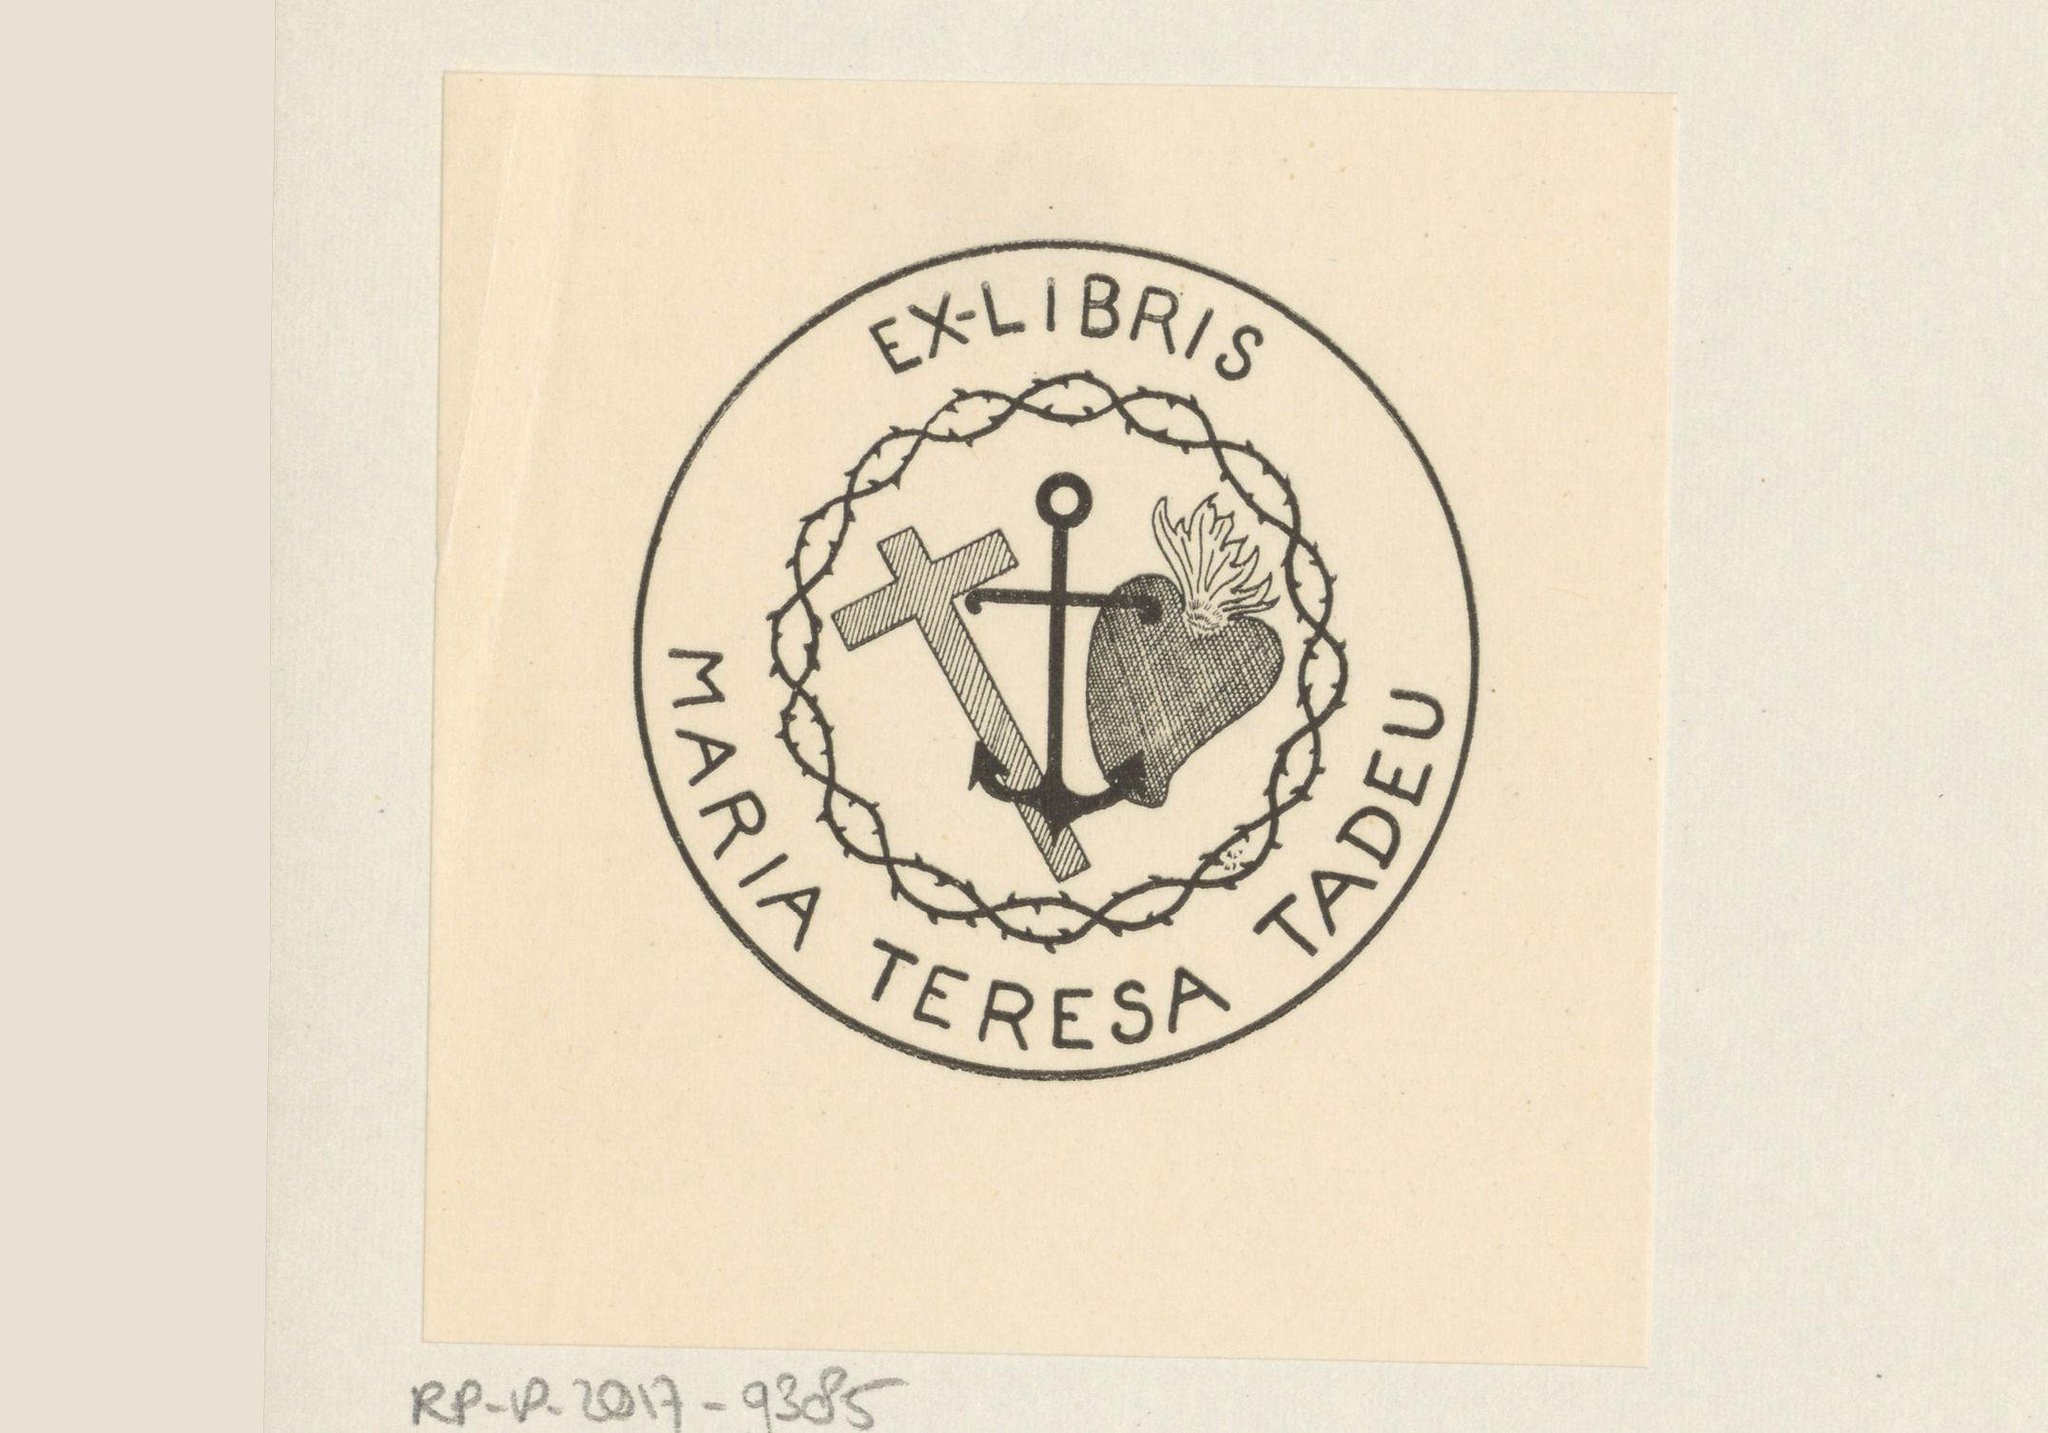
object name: bookplate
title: Ex libris van Maria Teresa Tadeu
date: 1947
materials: paper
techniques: printing block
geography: spain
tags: heart symbolism, crown of thorns ~ instruments of the passion, parts of ship's exterior: anchor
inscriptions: date